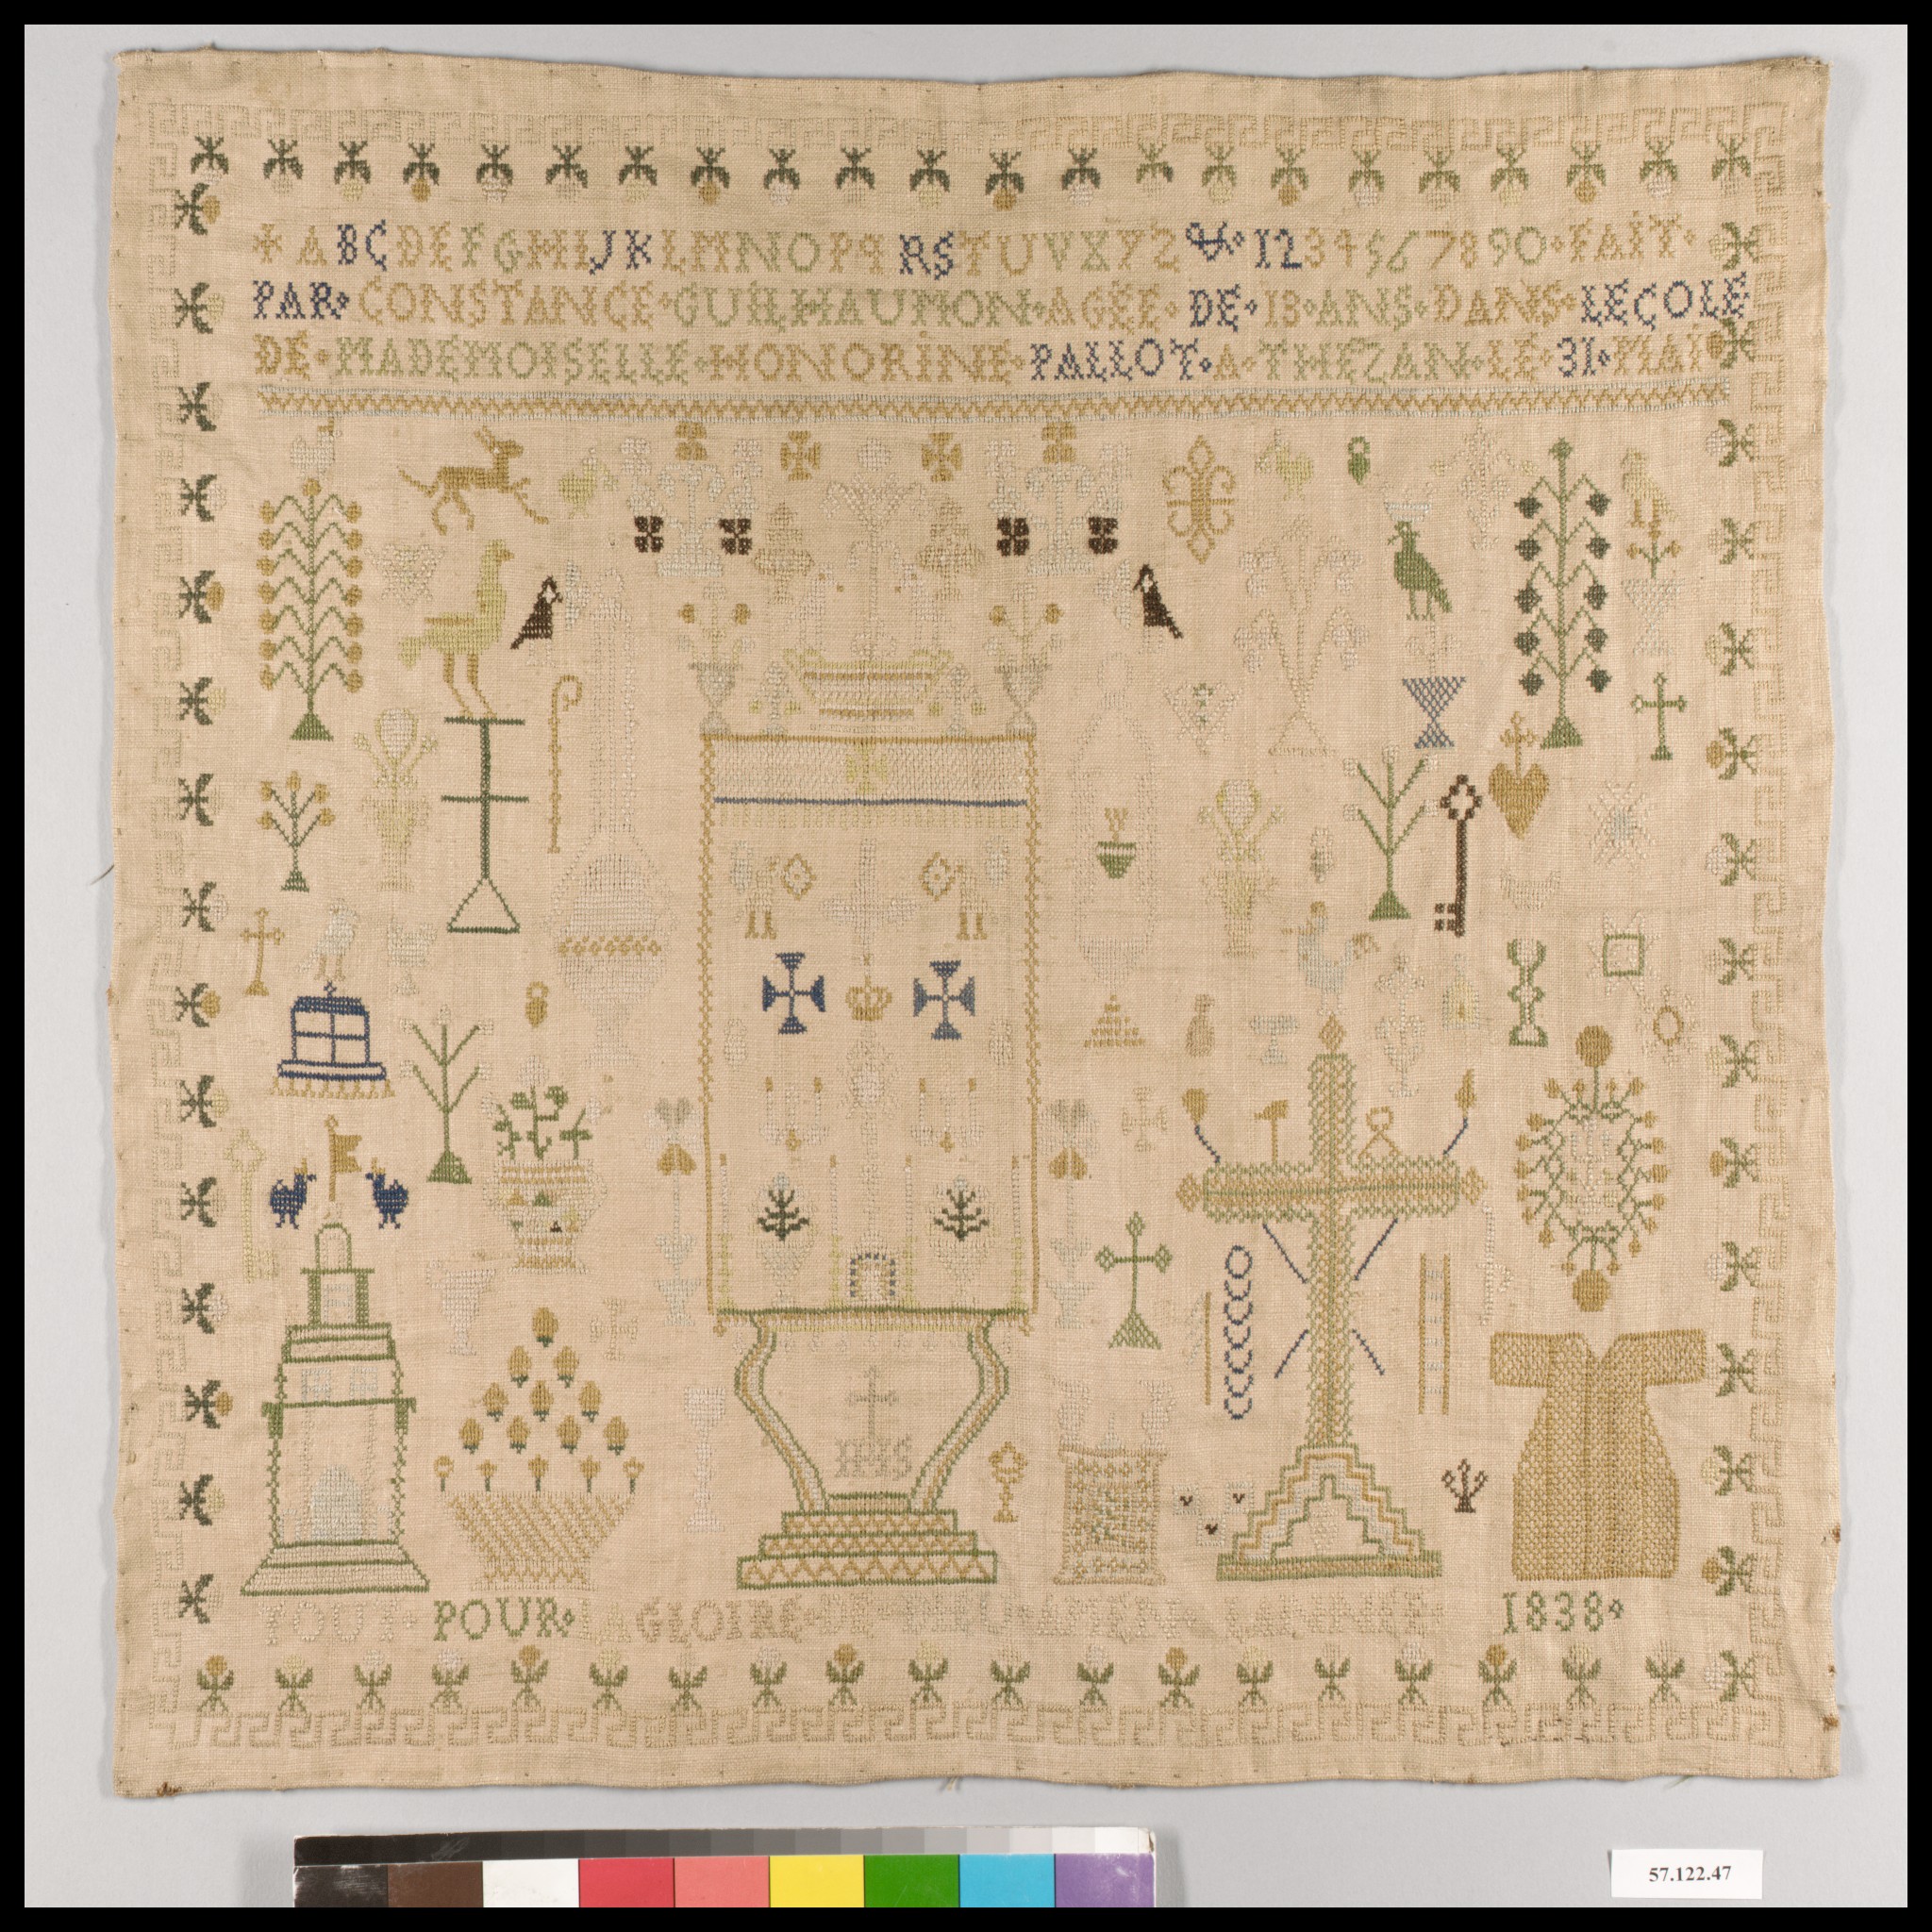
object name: sampler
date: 1838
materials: linen, silk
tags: animals,birds,cross